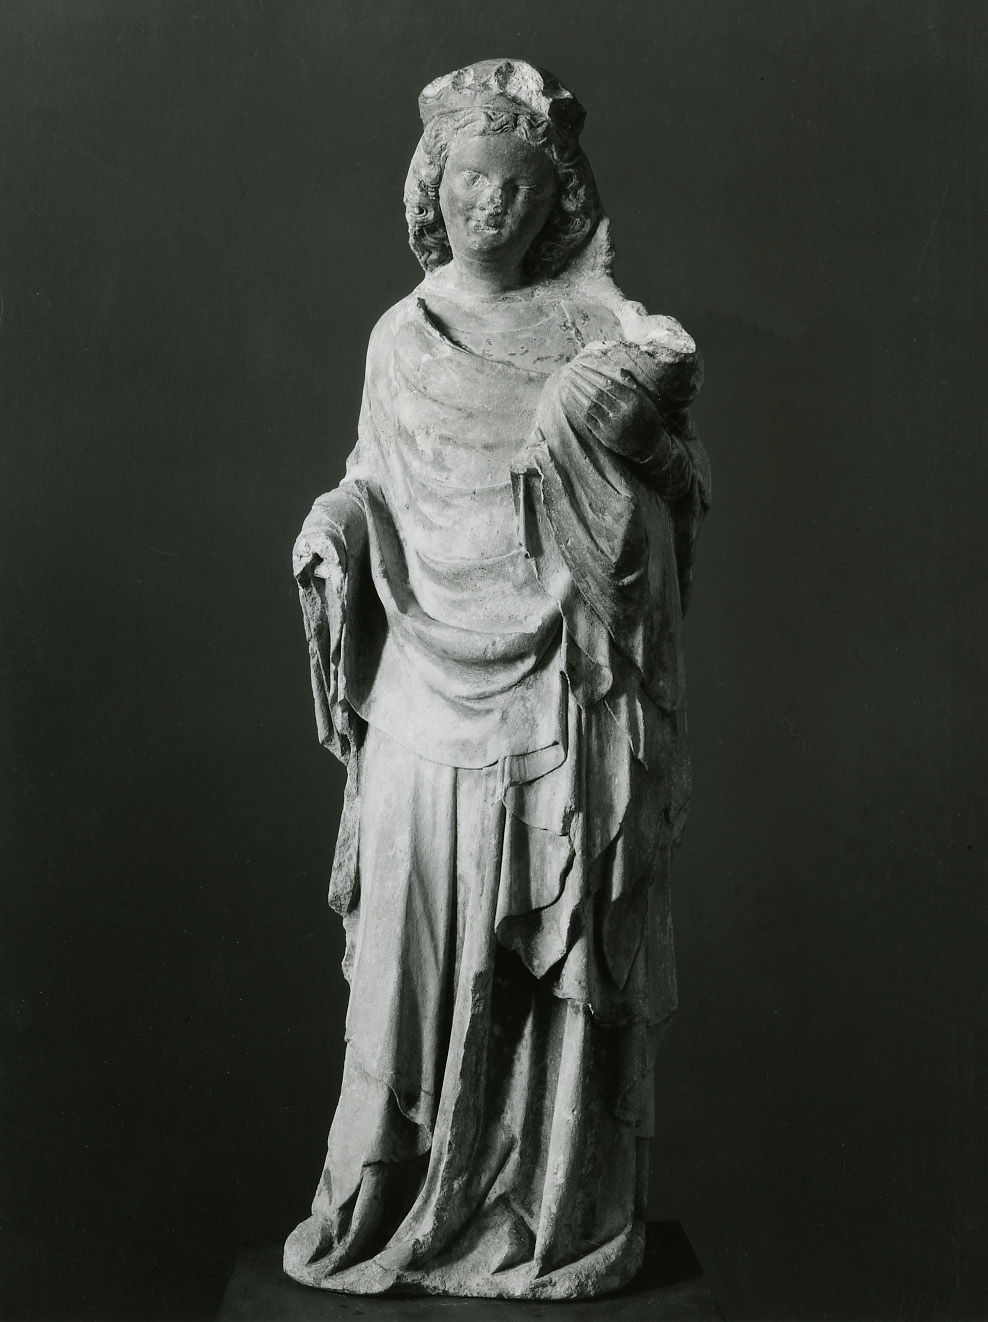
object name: statuette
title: Virgin and Child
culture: french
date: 1301-1400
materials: paint, stone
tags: madonna and child